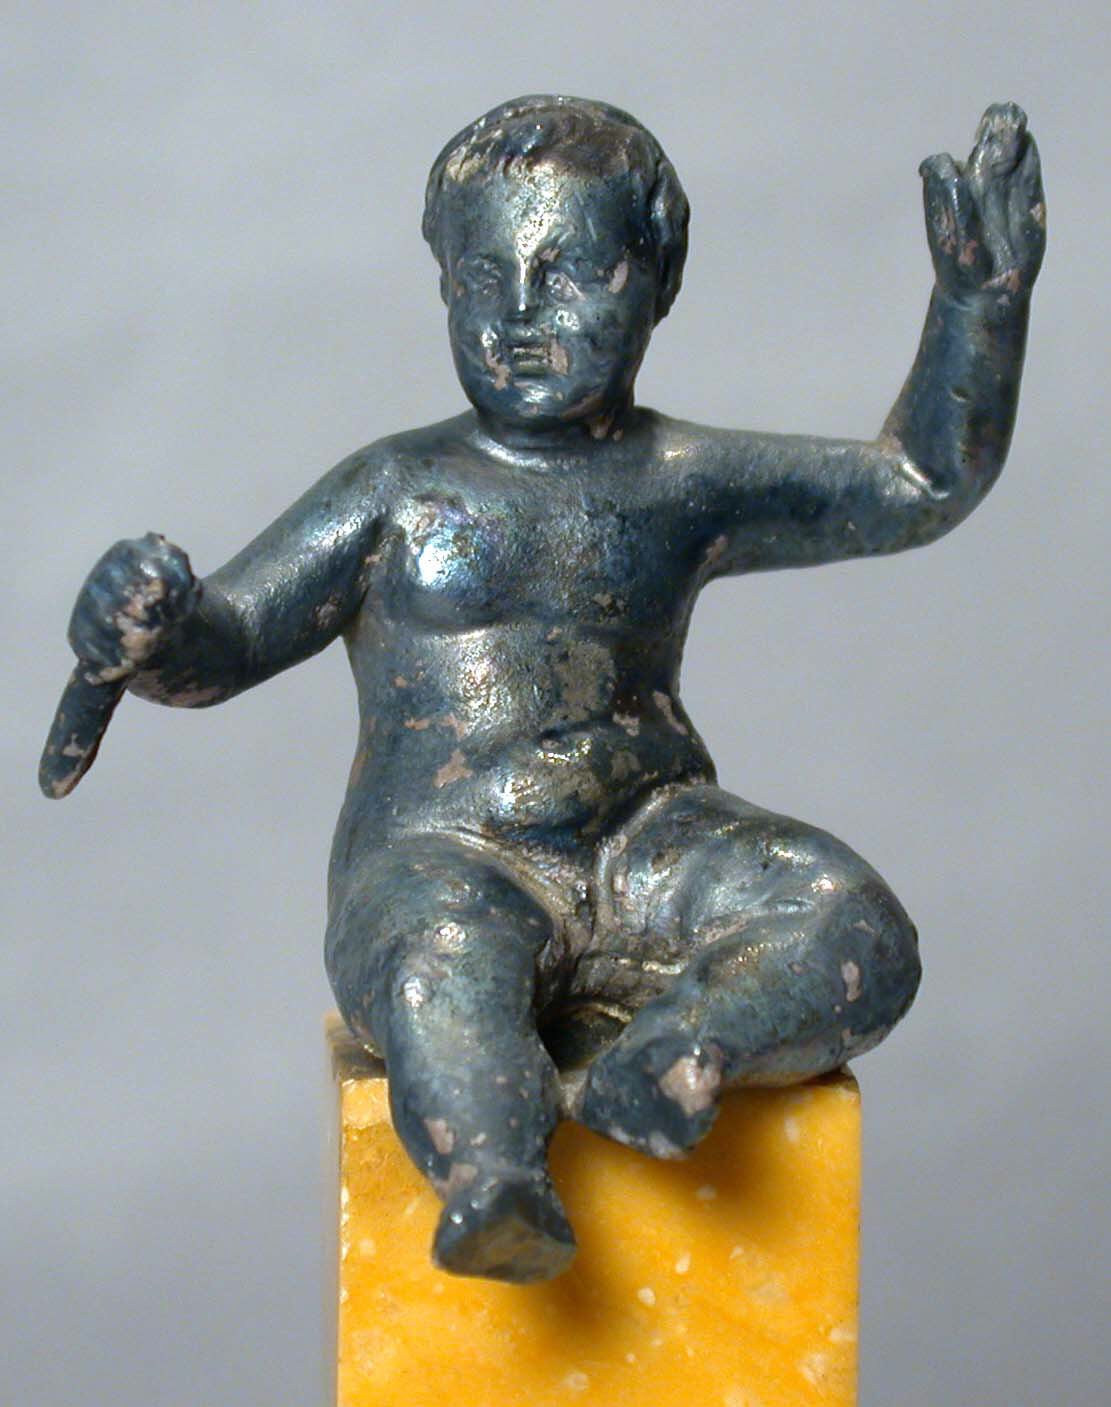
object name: statuette of a boy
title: Silver statuette of a seated boy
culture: greek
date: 300-201 BCE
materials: silver